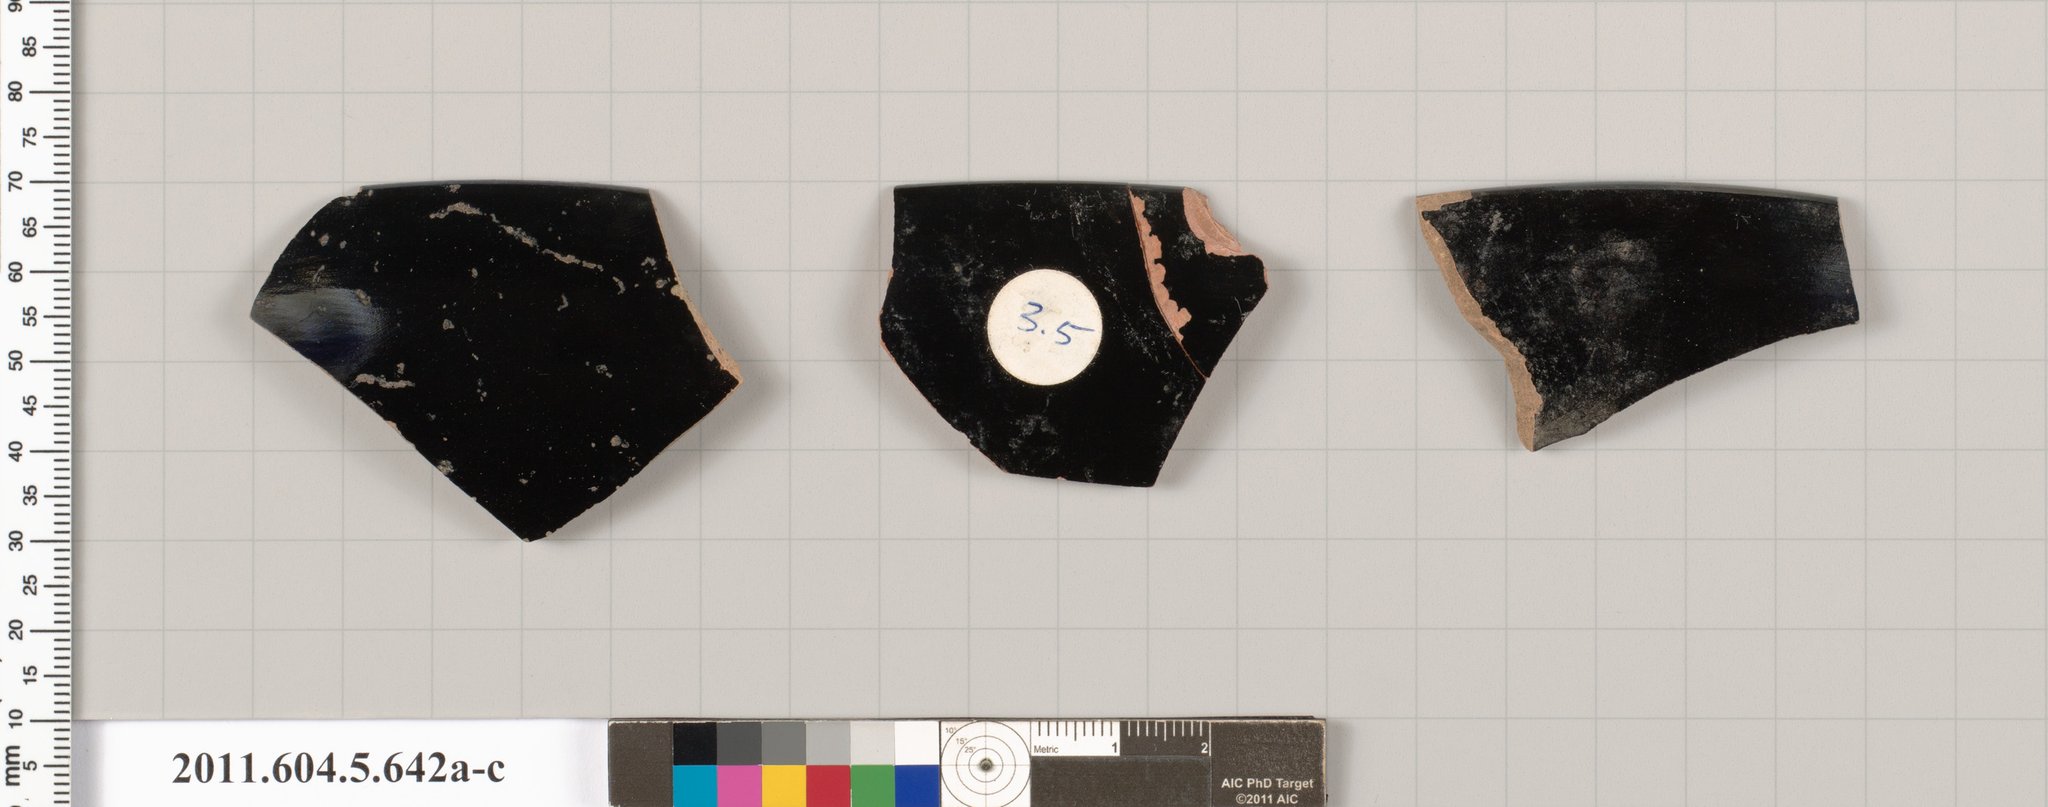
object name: kylix fragment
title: Terracotta rim fragments of kylikes (drinking cups)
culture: greek, attic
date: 600-401 BCE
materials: terracotta